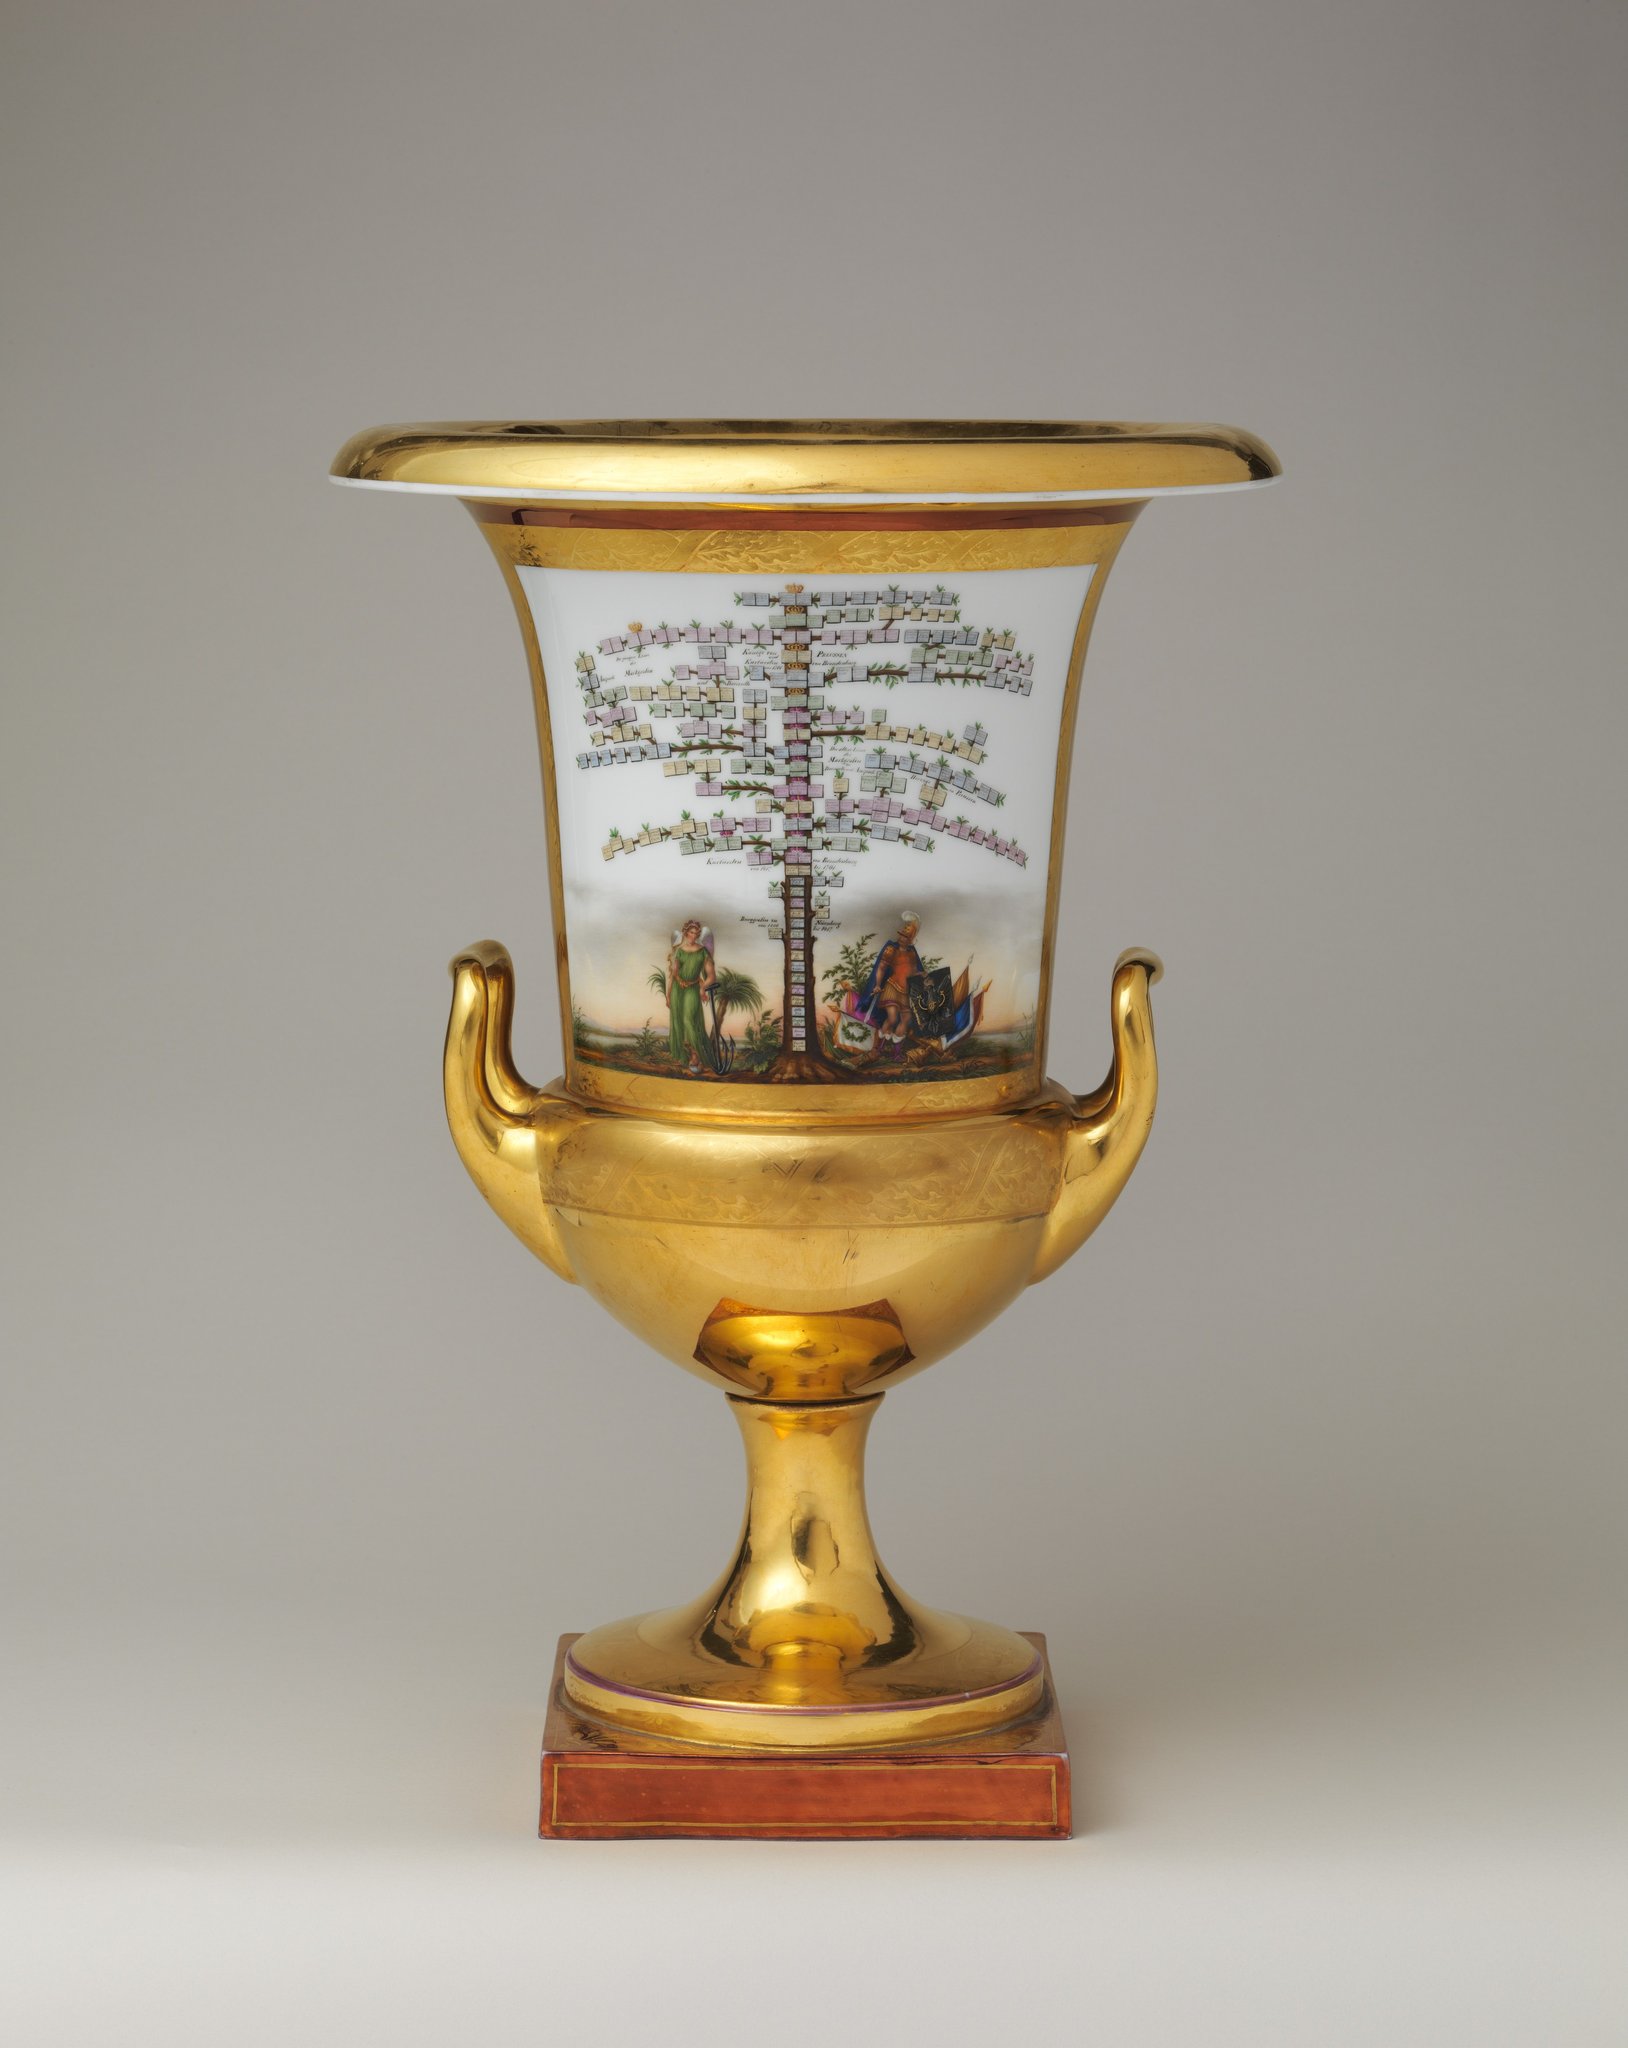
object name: vase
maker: royal porcelain manufactory, berlin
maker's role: manufactory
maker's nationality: german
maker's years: 1763-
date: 1820-1825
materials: hard paste porcelain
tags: men,trees